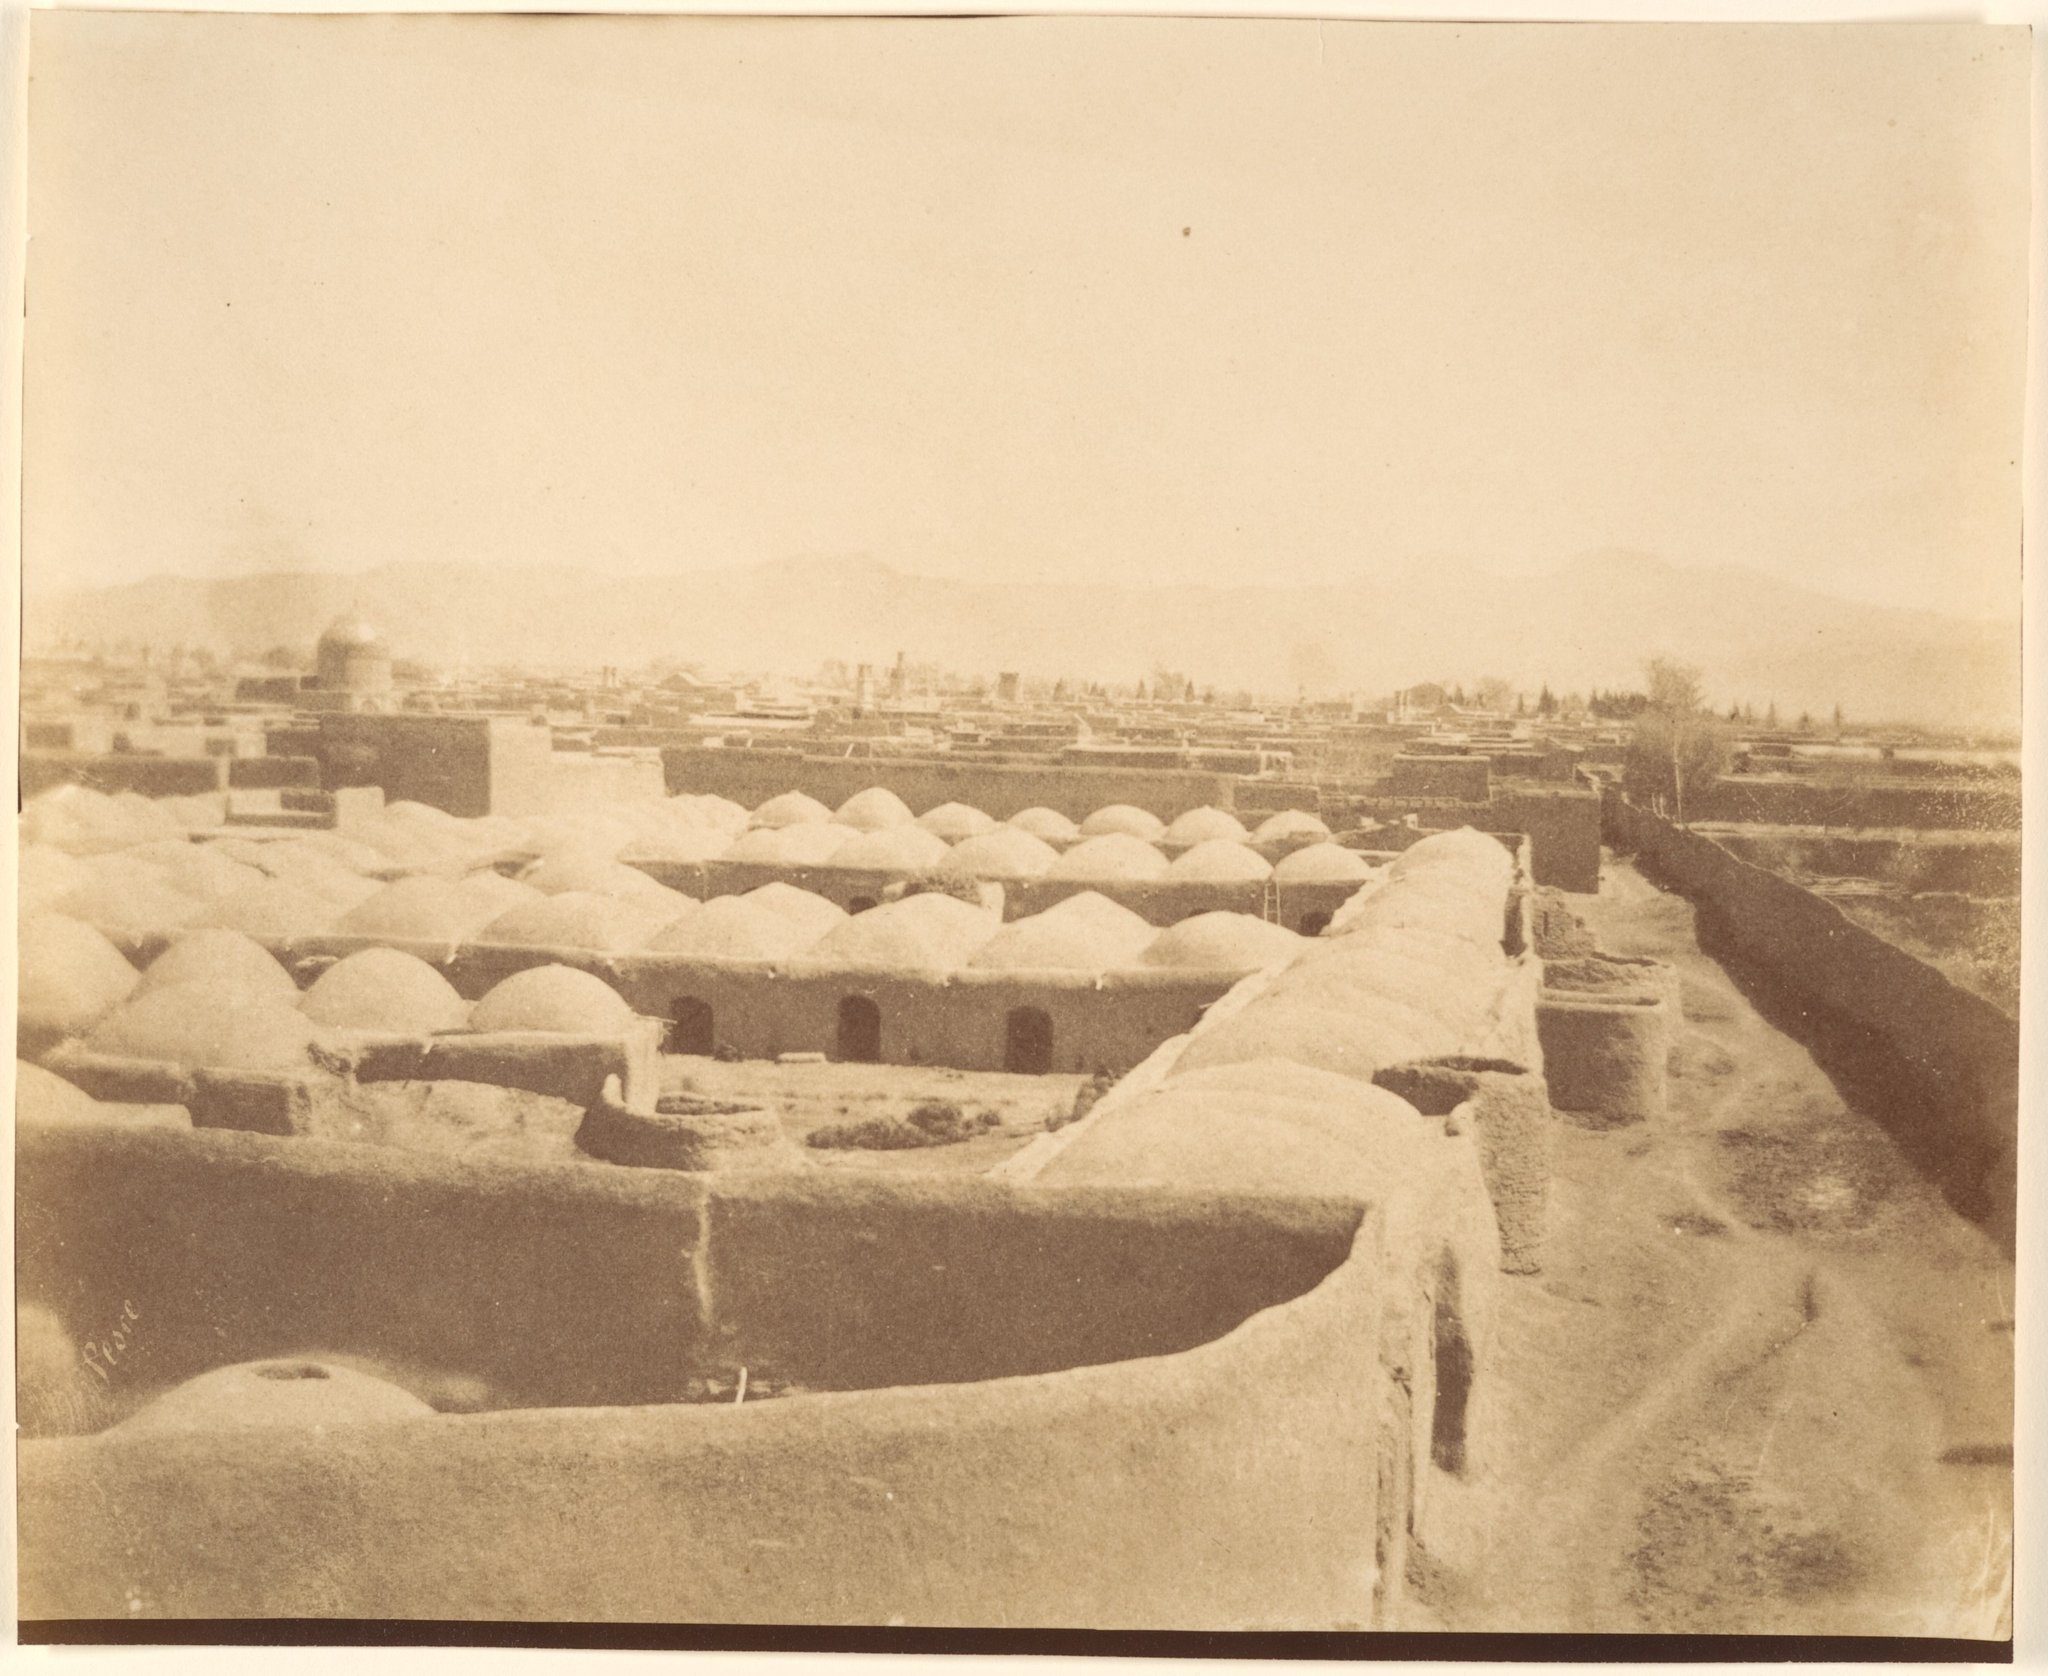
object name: photograph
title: [South Gate of the Arq, Teheran, Iran]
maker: luigi pesce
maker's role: artist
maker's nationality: italian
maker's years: 1818-1891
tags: architecture